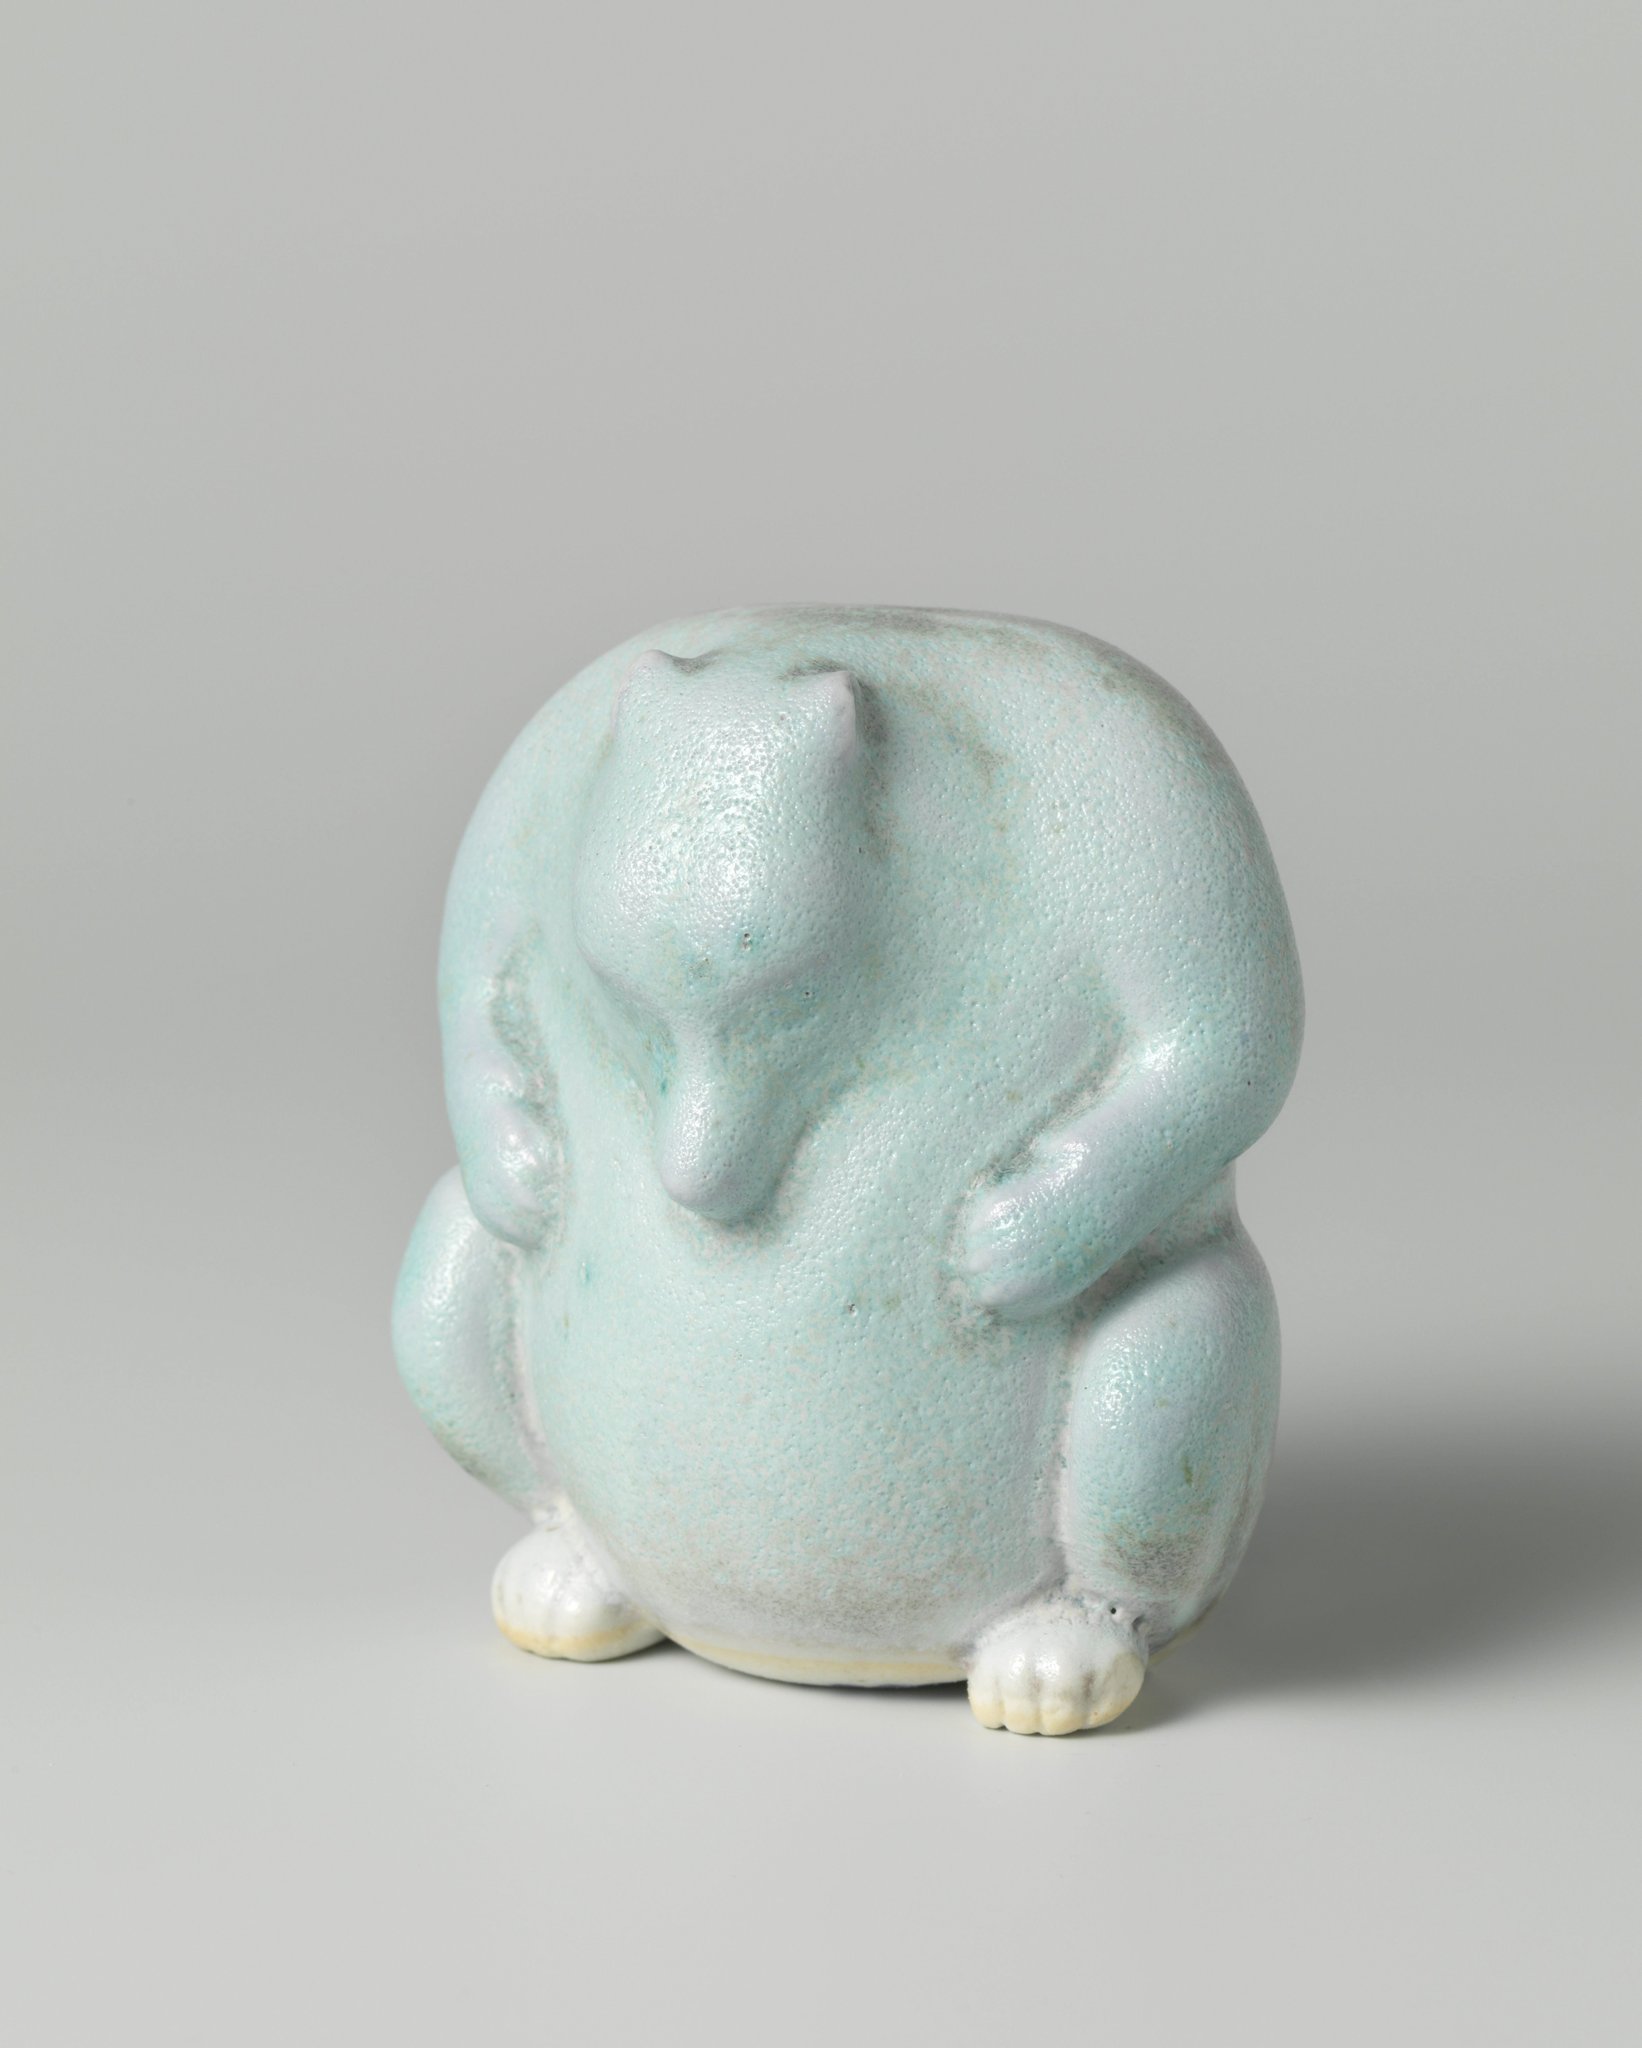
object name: decoratief object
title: Bear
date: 1891-1895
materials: glaze, stoneware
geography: choisy-le-roi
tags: beasts of prey, predatory animals: bear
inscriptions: signature and date: ‘geschilderde rozenkrans waarbinnen I.T..’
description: The ceramicist Chaplet was known for his exceptional glazes. Here he used a strikingly matt, pale turquoise glaze. A sculptor friend made the model of the little bear for him.